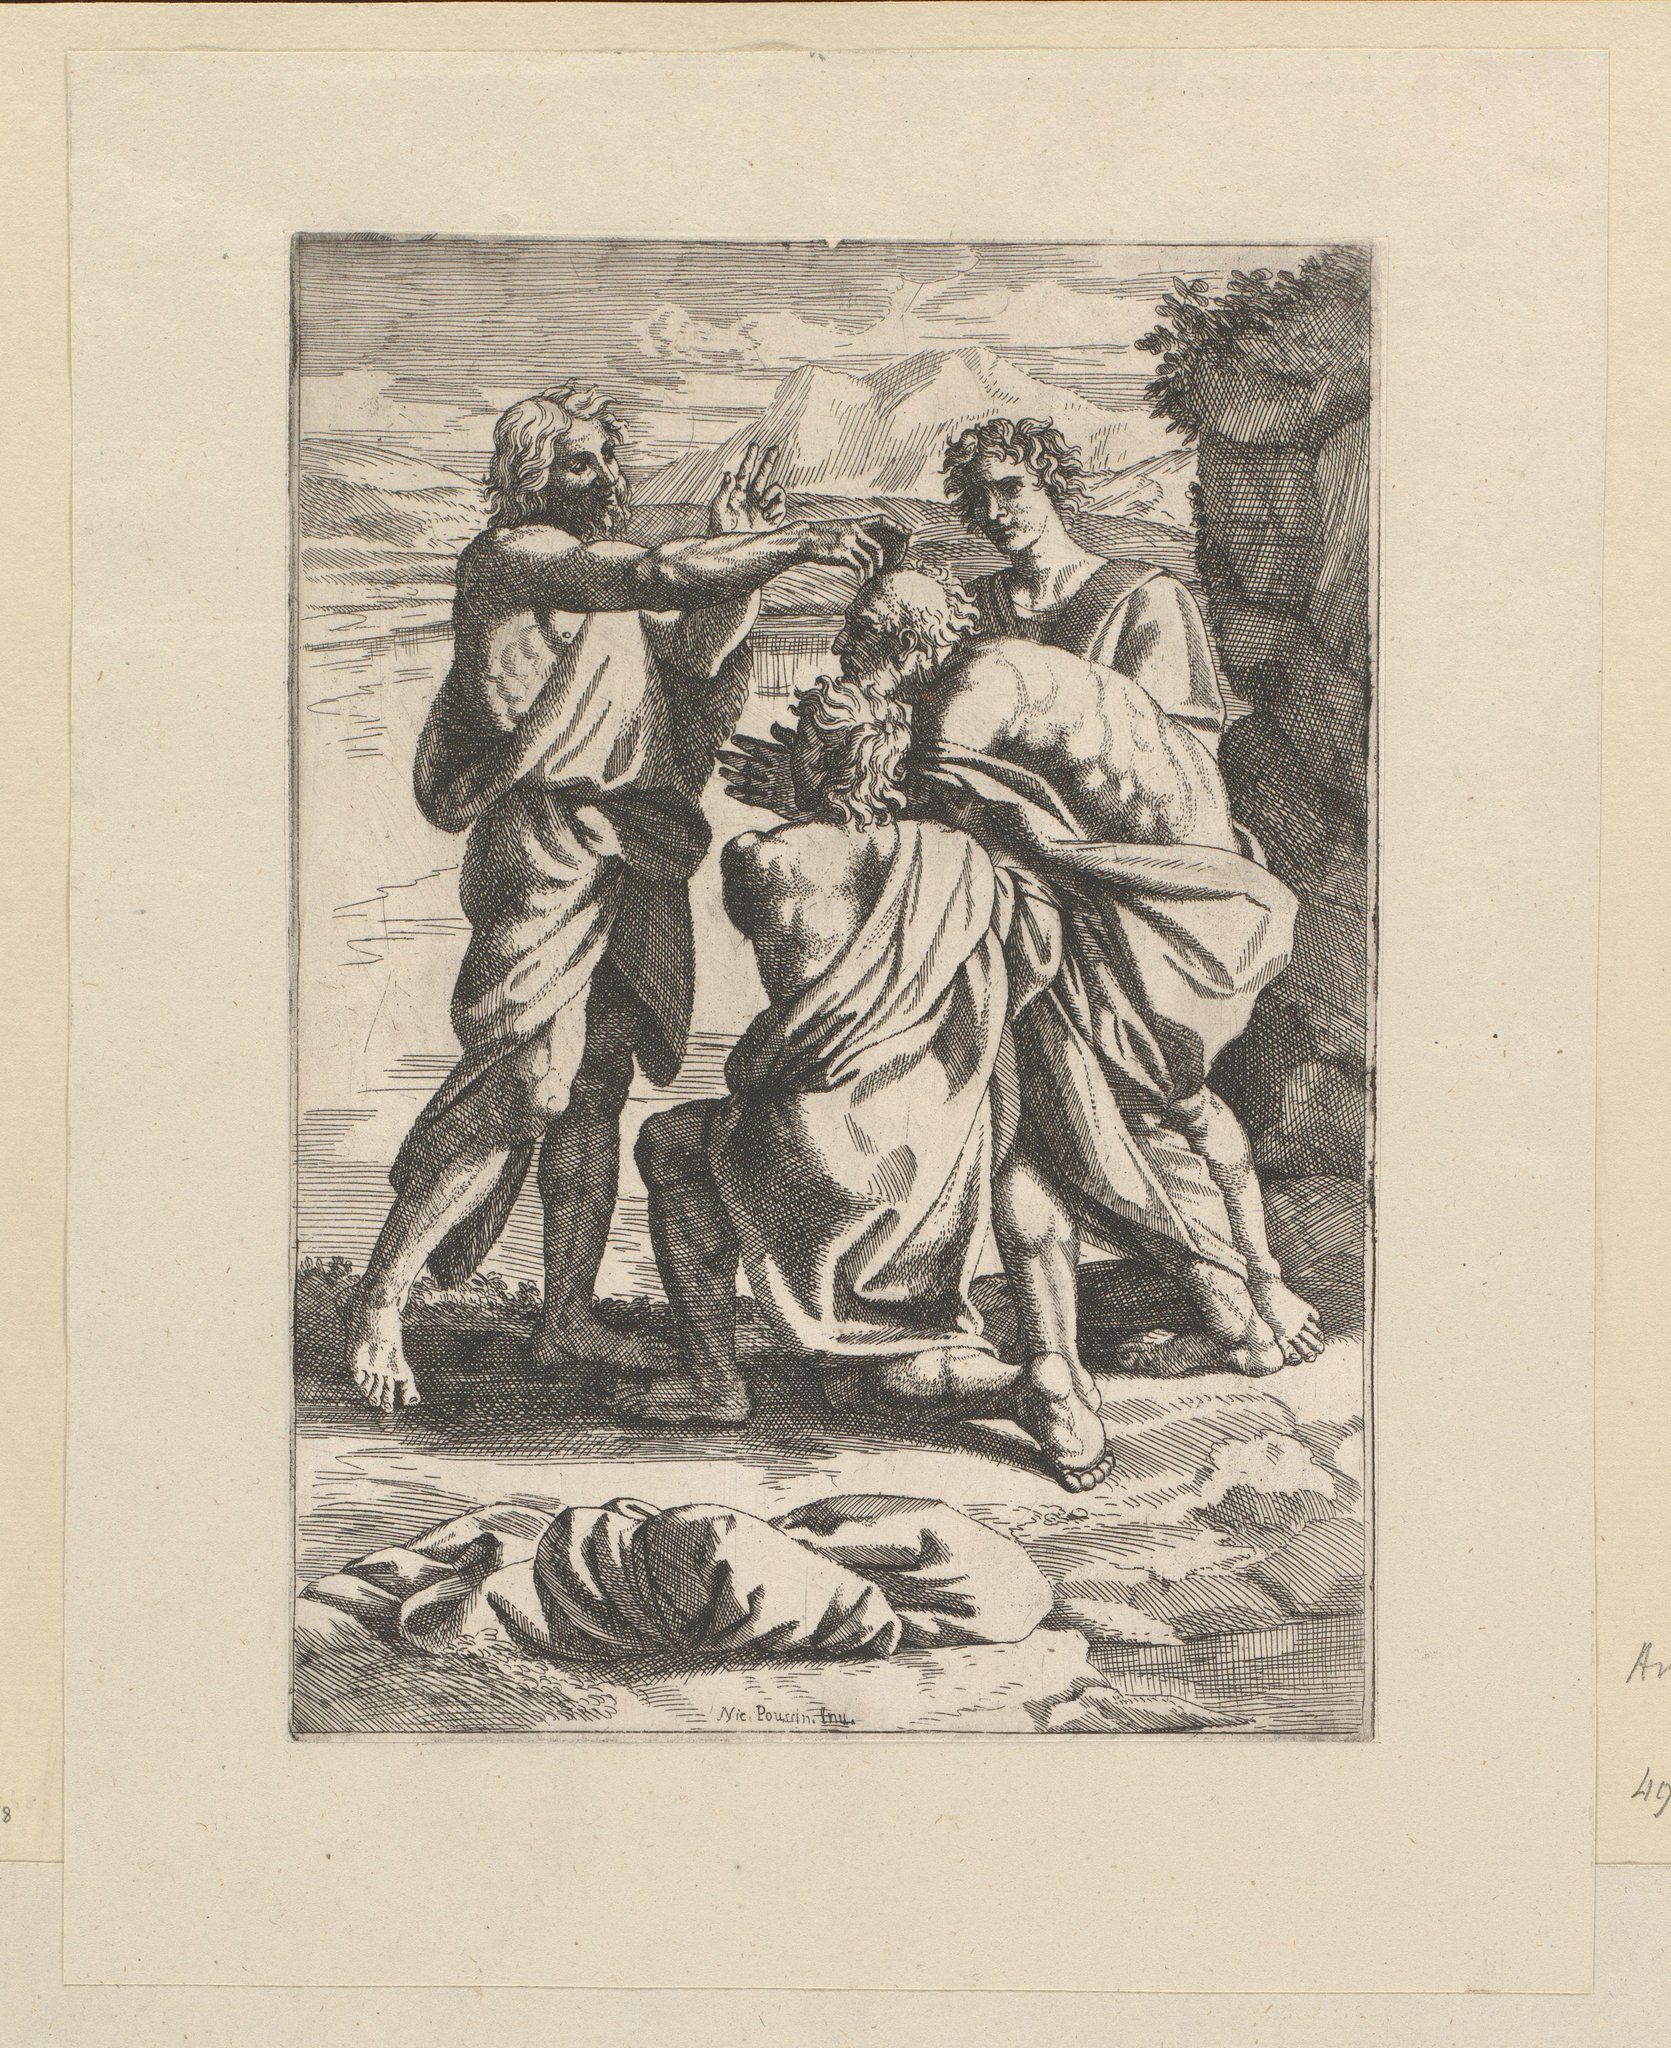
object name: print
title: Johannes doopt in de Jordaan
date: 1650-1700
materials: paper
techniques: engraving, etching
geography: france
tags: john the baptist baptizing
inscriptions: collector's mark: Lugt 240